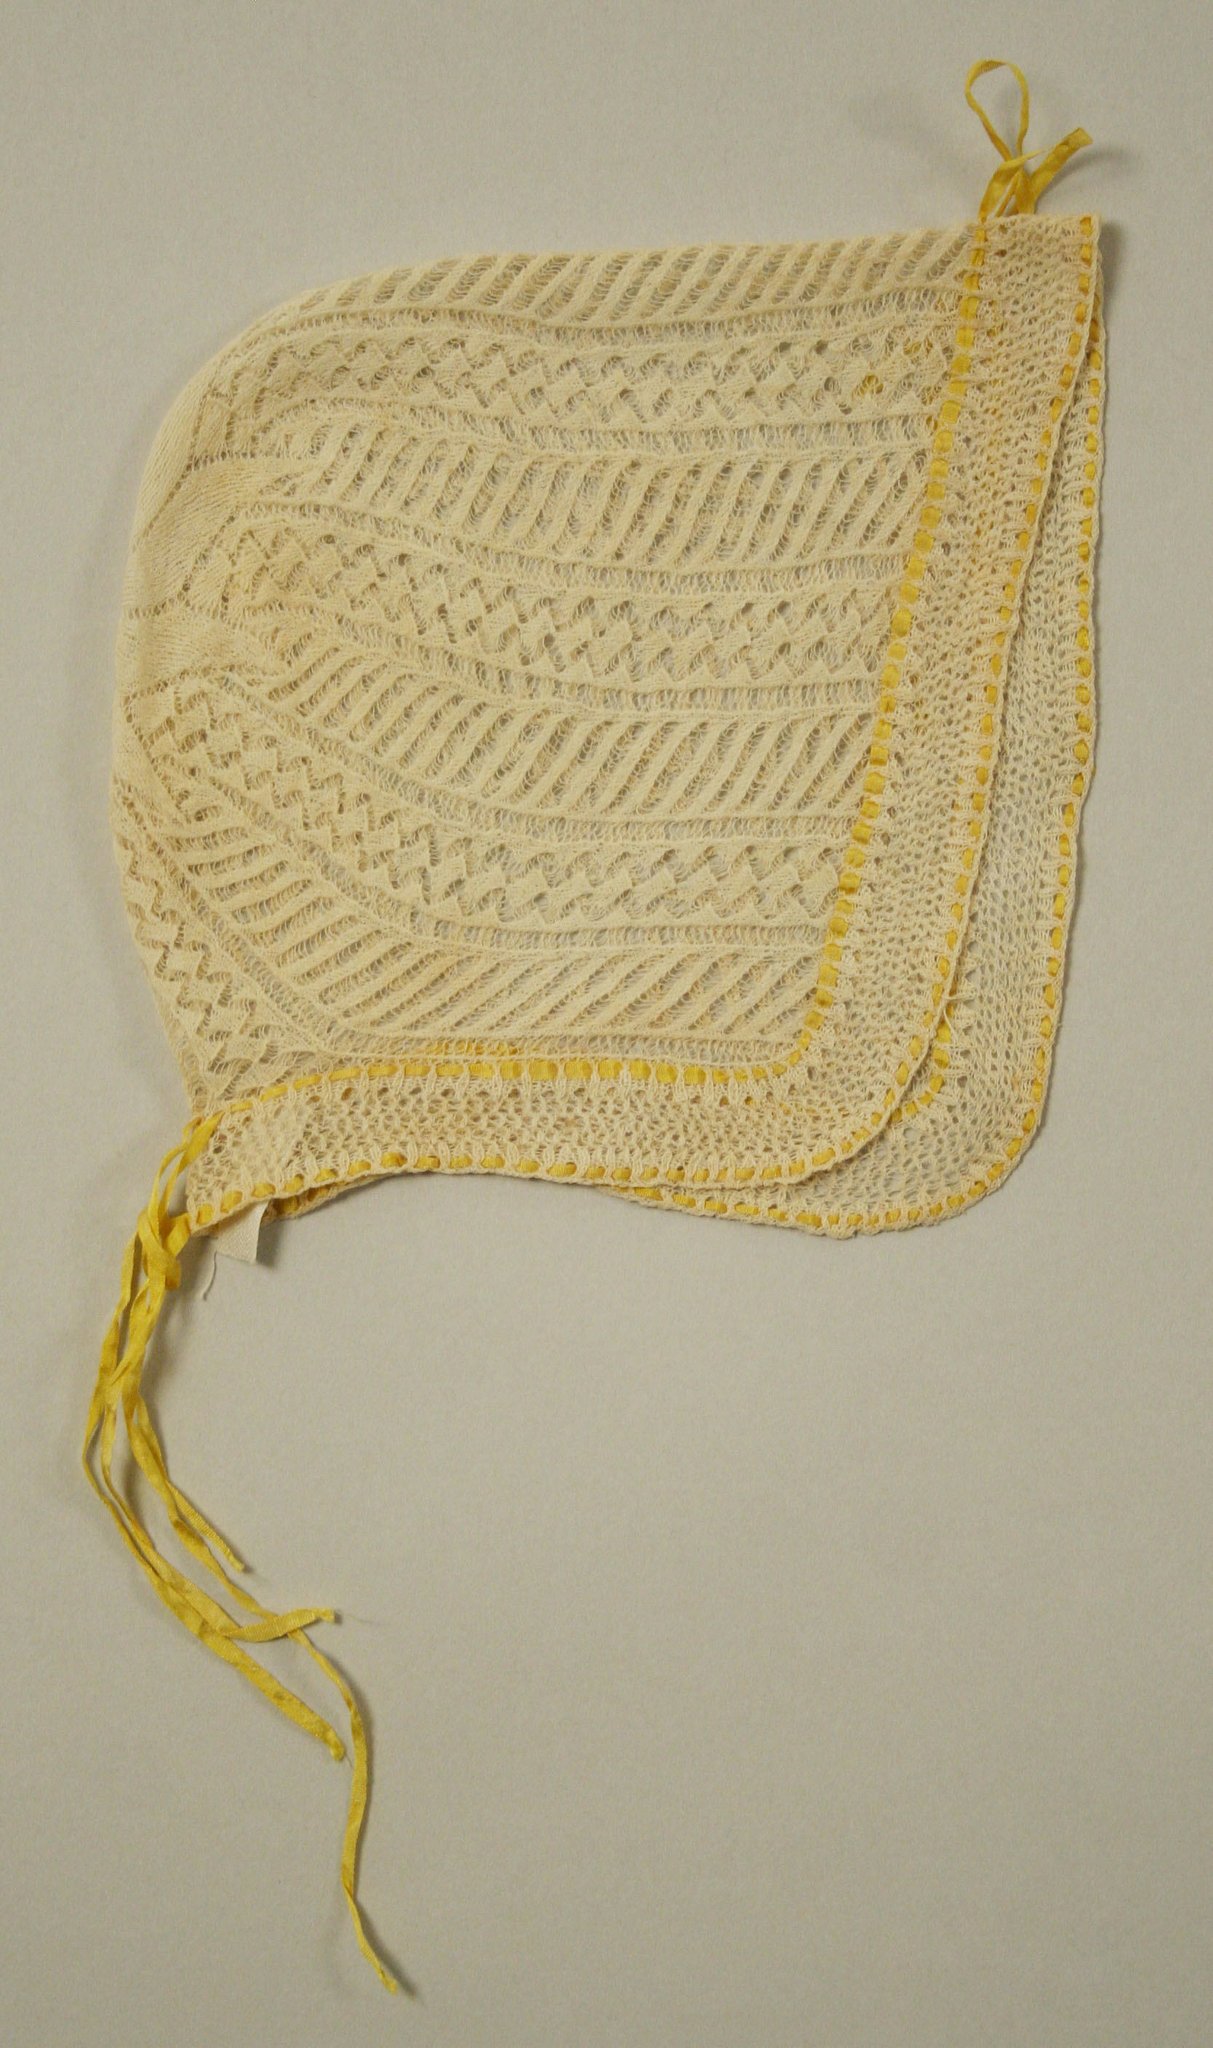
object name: cap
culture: german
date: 1801-1900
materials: cotton